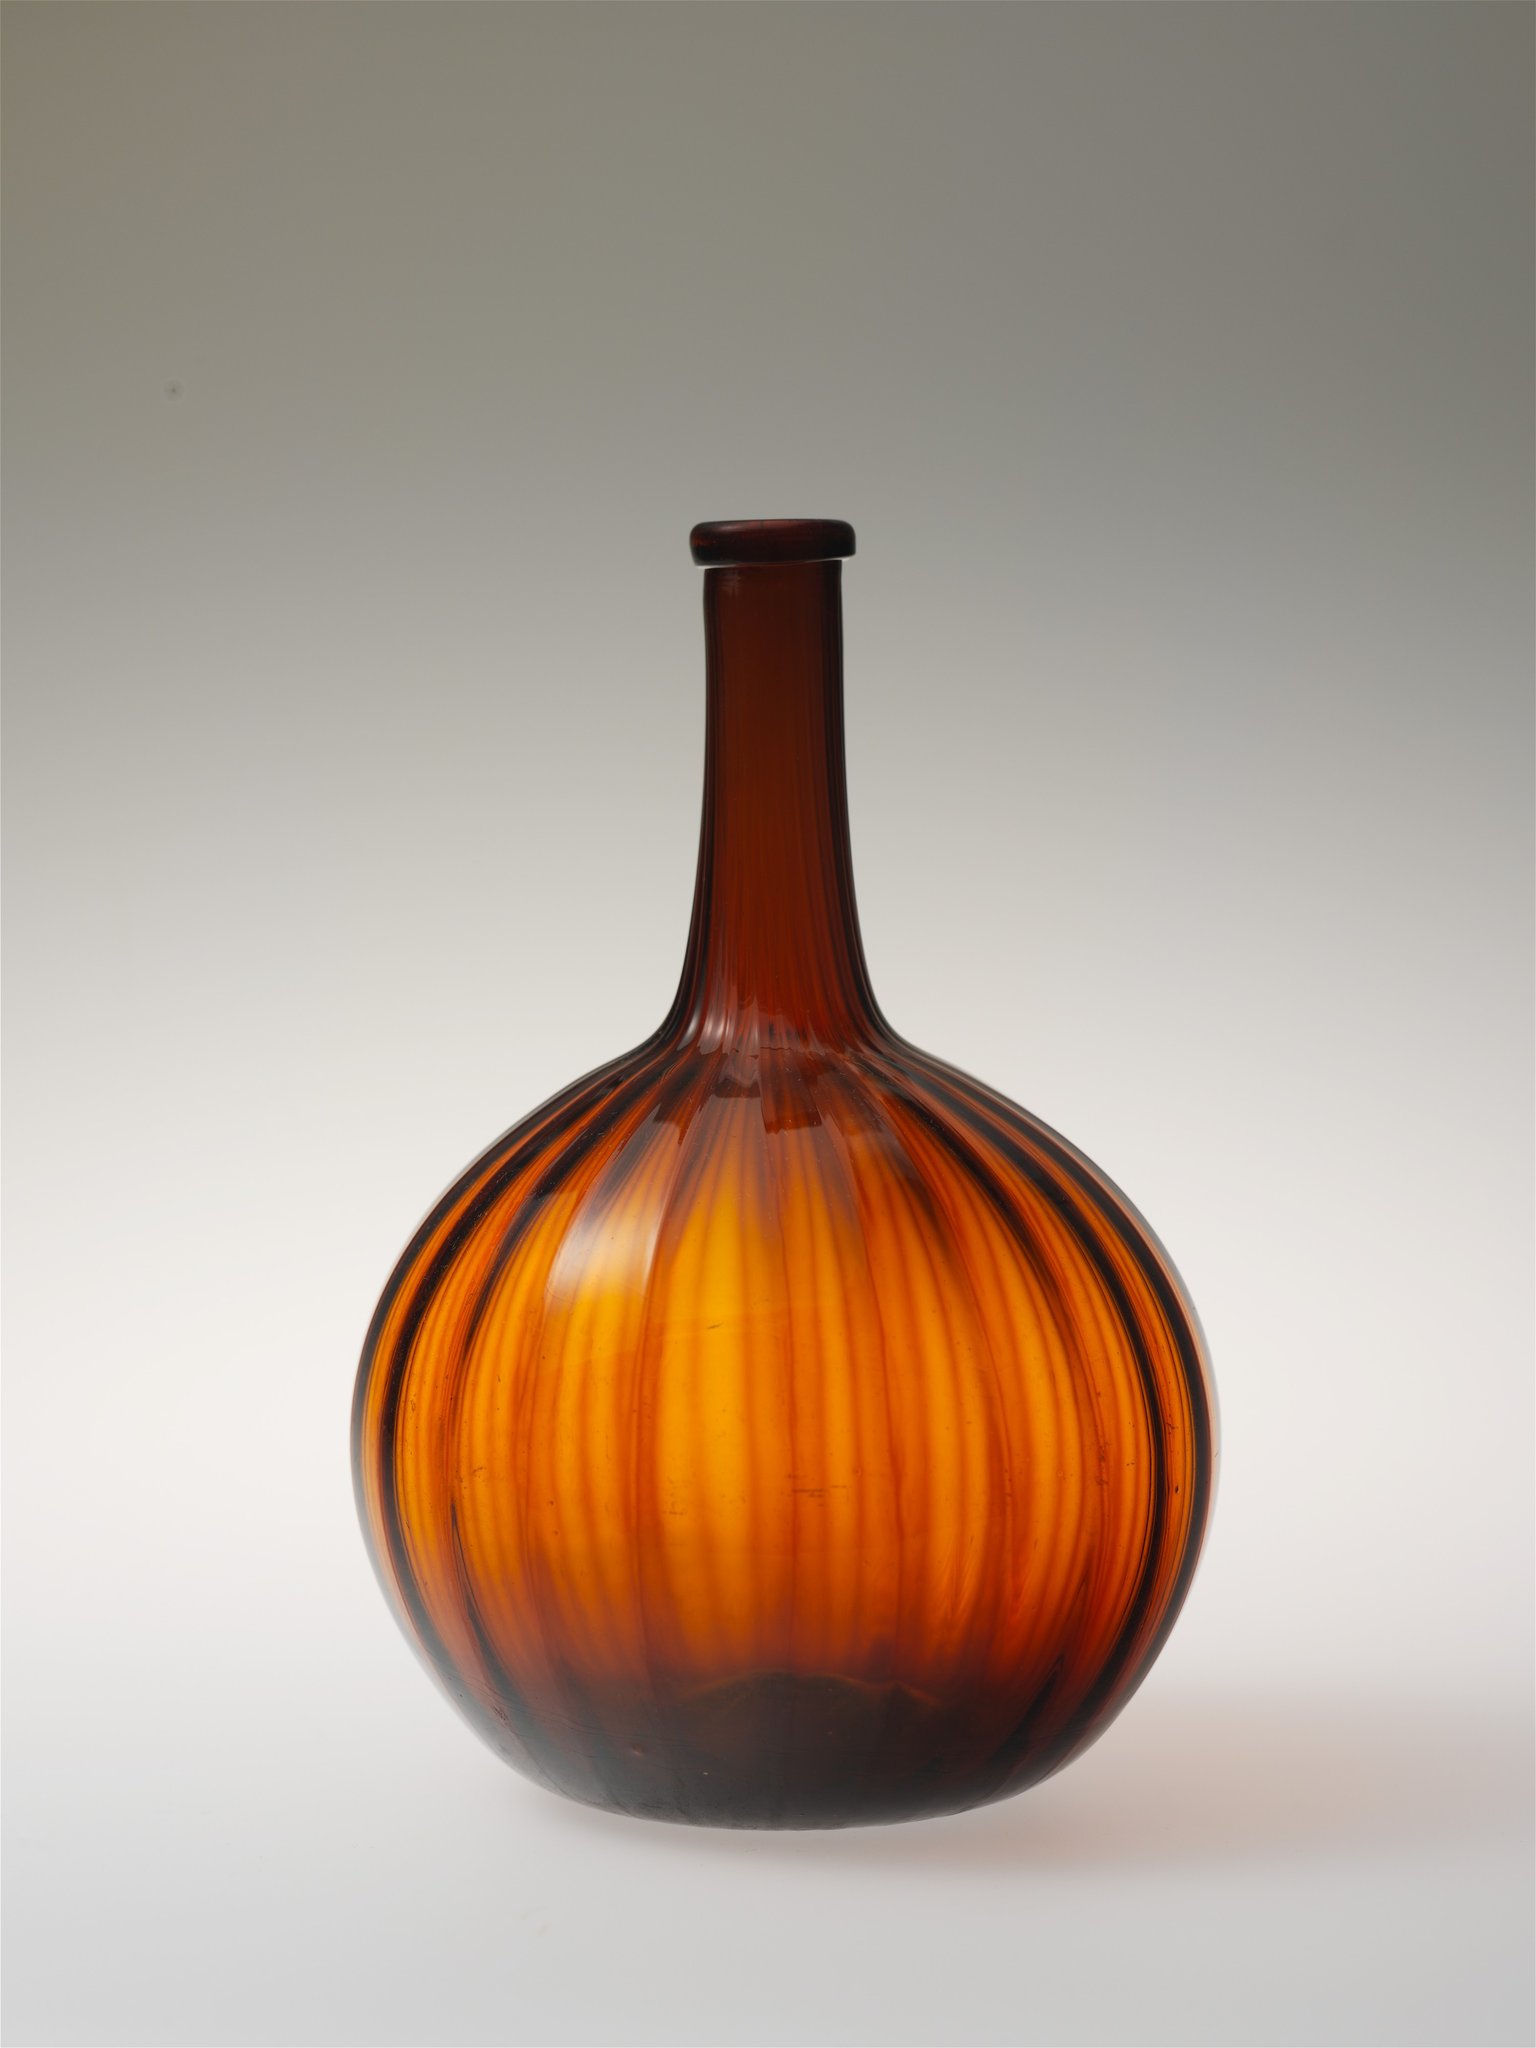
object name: bottle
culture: american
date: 1815-1845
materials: glass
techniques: glassblowing, molding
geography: united states